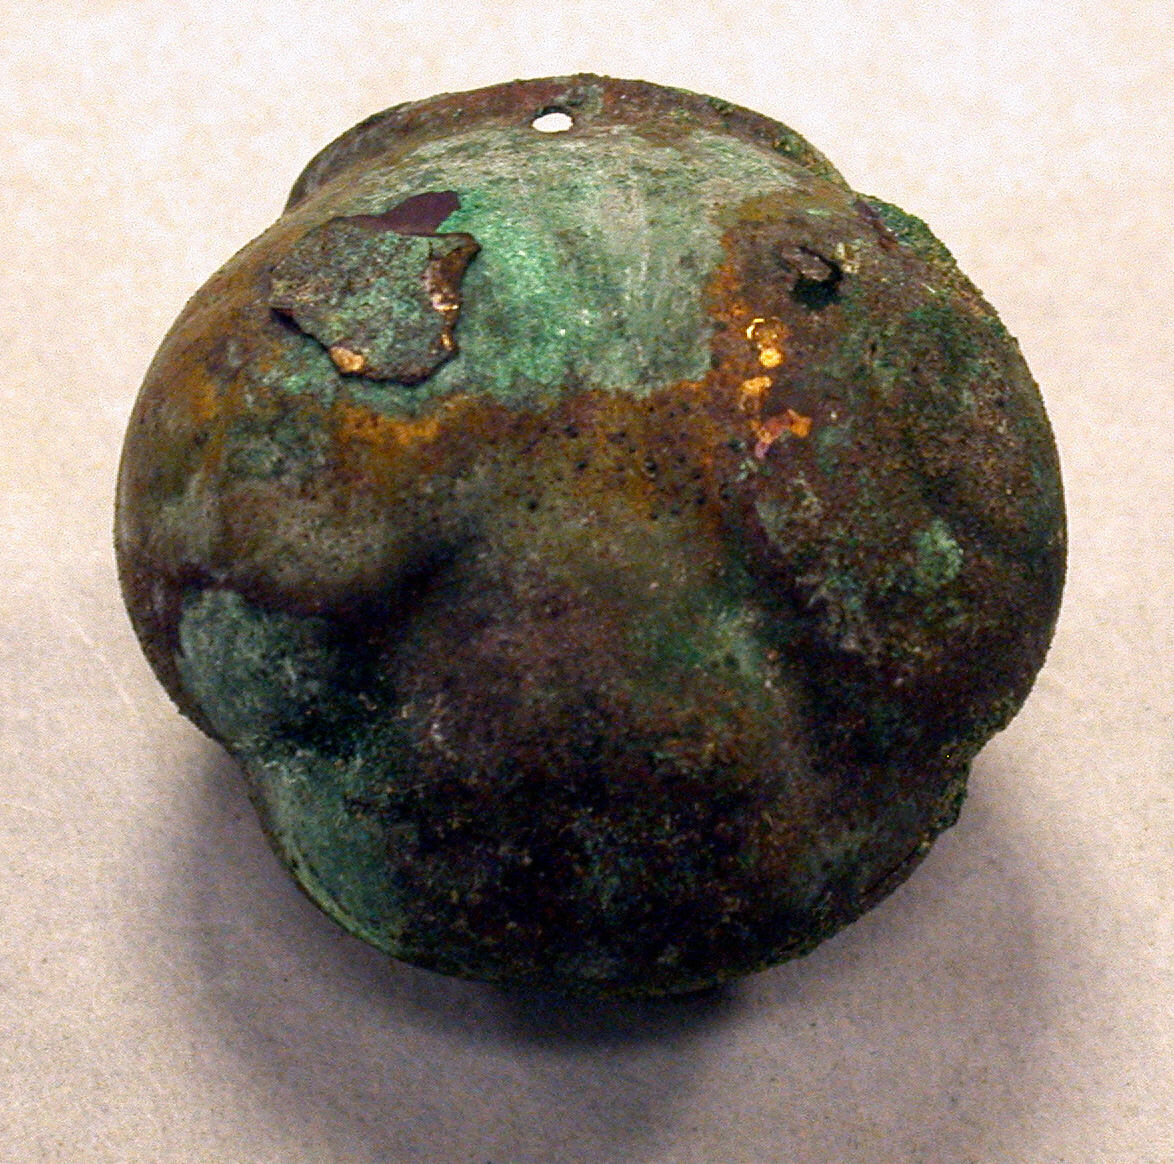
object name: head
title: Head of a Frog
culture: moche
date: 501-700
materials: gilt copper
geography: peru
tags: frogs